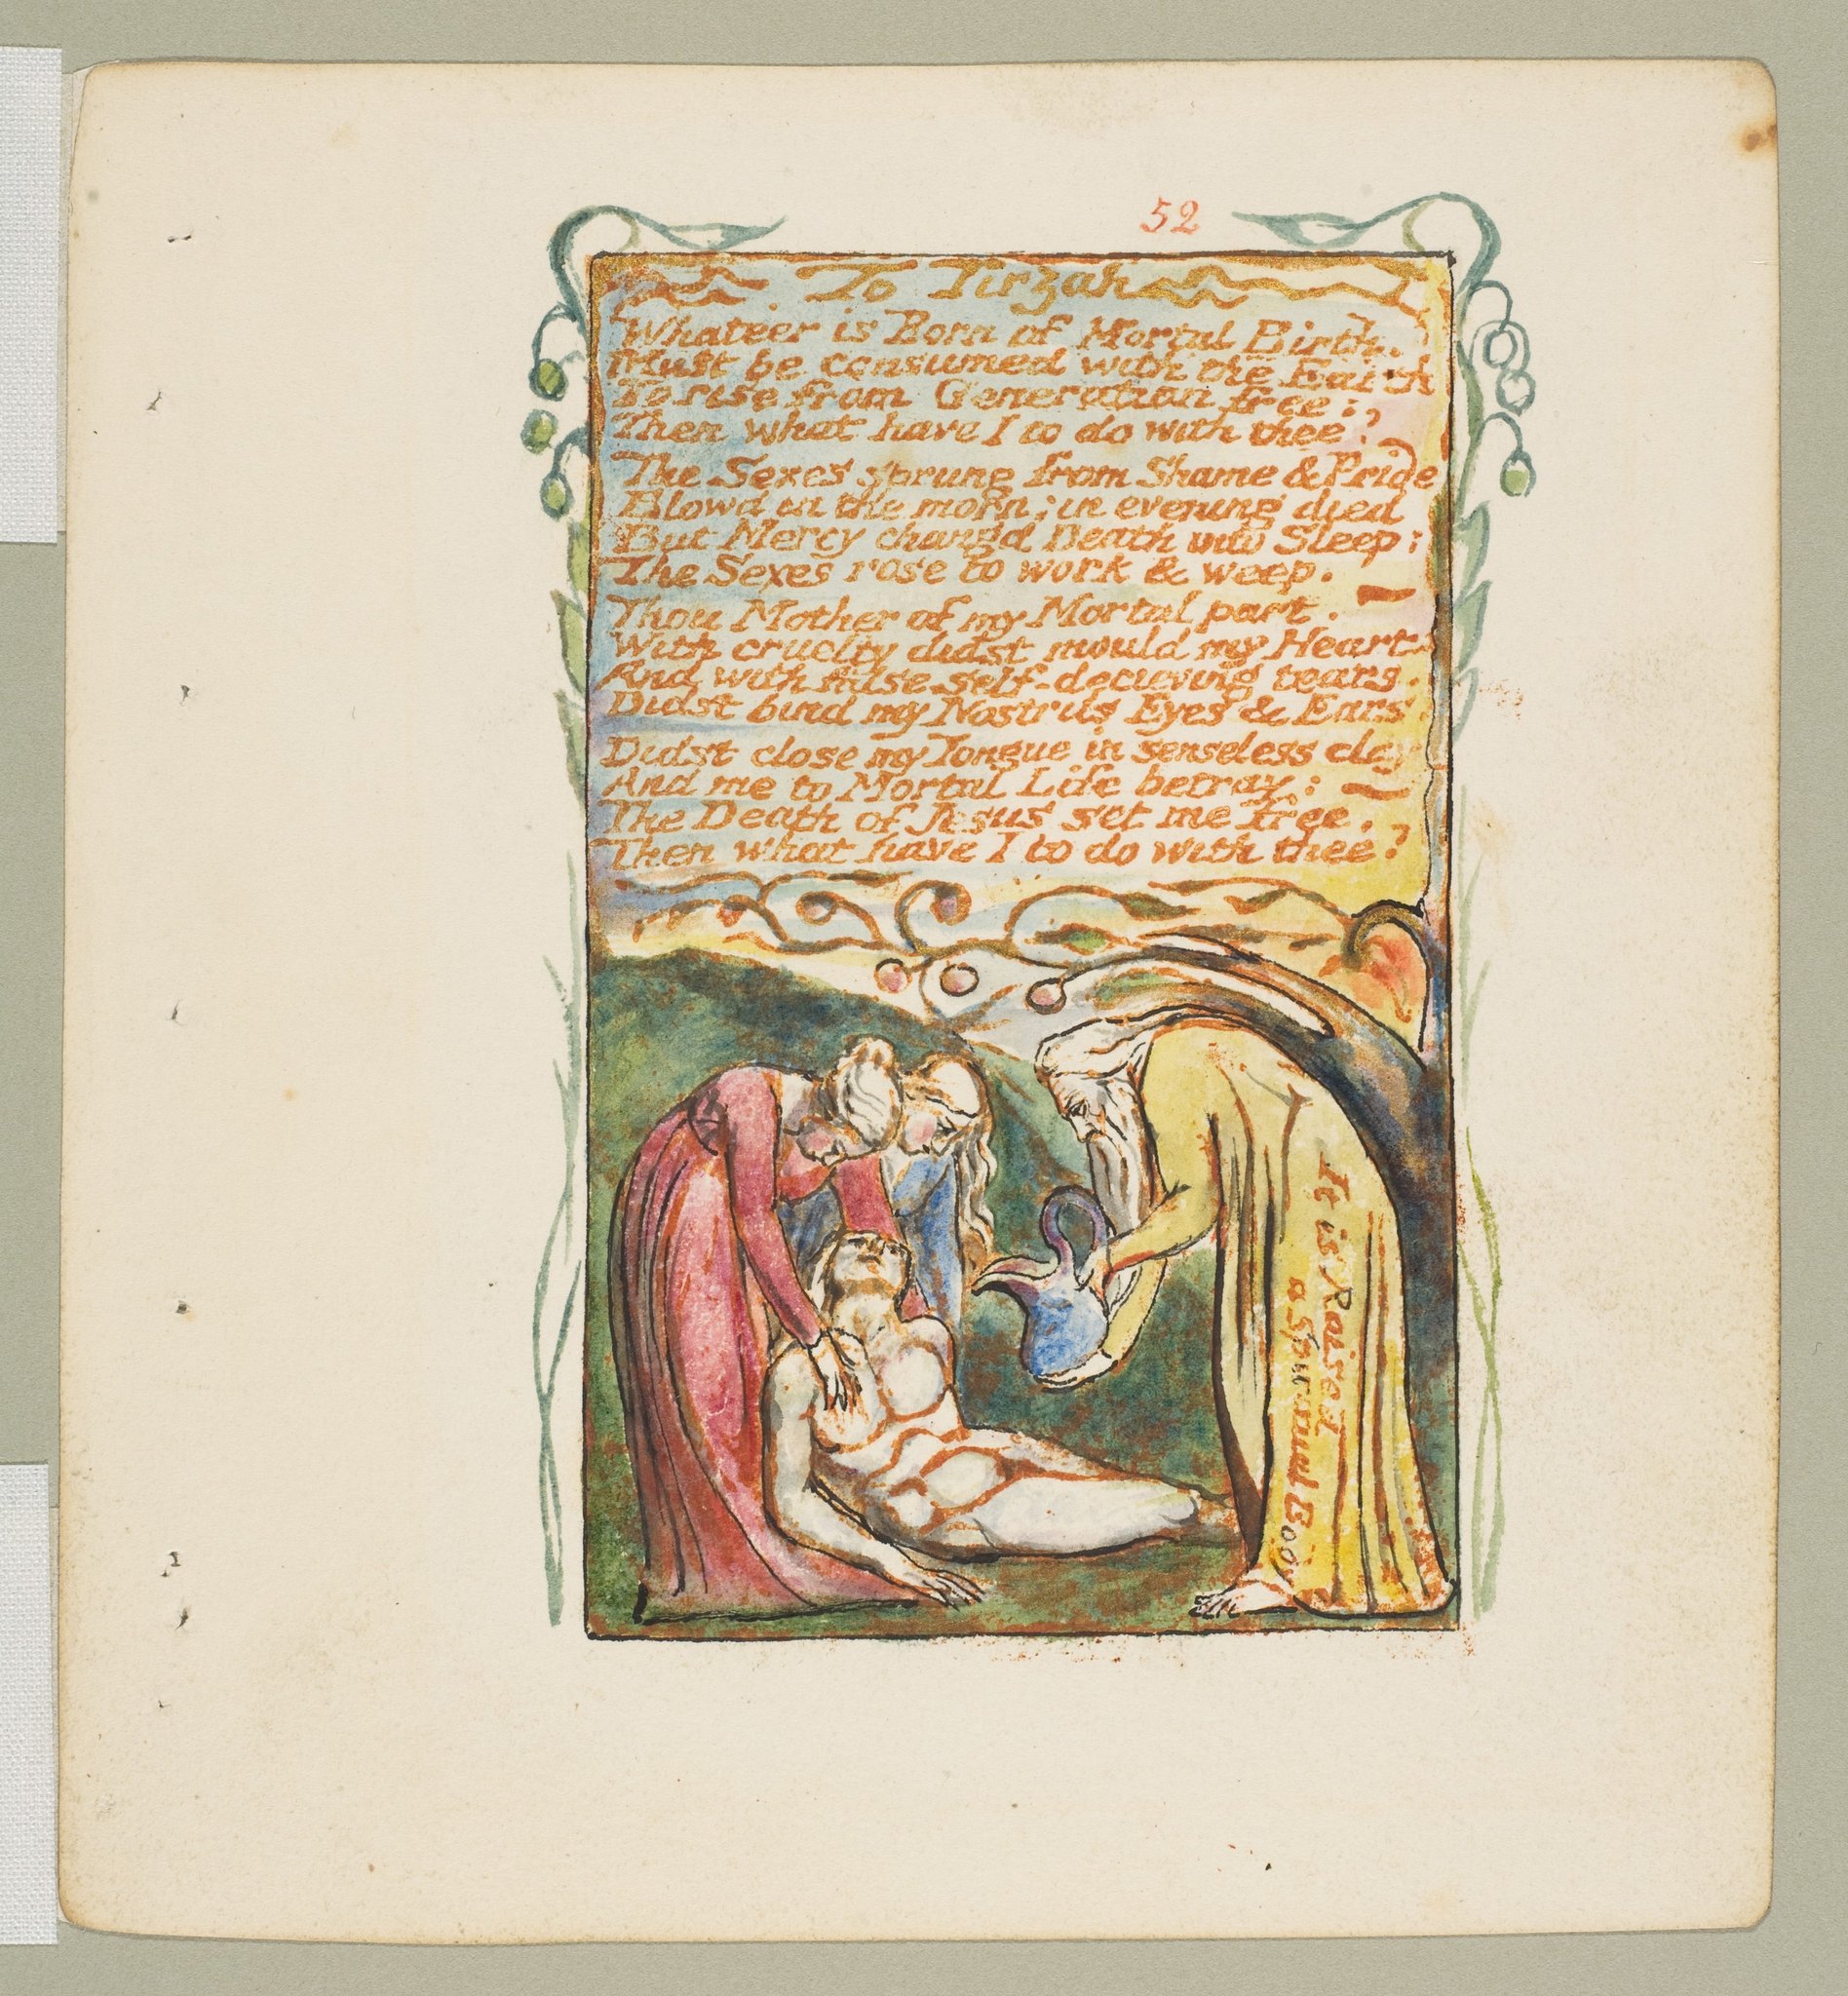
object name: print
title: Songs of Experience: To Tirzah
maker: william blake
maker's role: artist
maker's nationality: british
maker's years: 1757-1827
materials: gold, ink, shell, watercolor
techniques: etching, hand coloring, printing, relief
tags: poetry,men,women